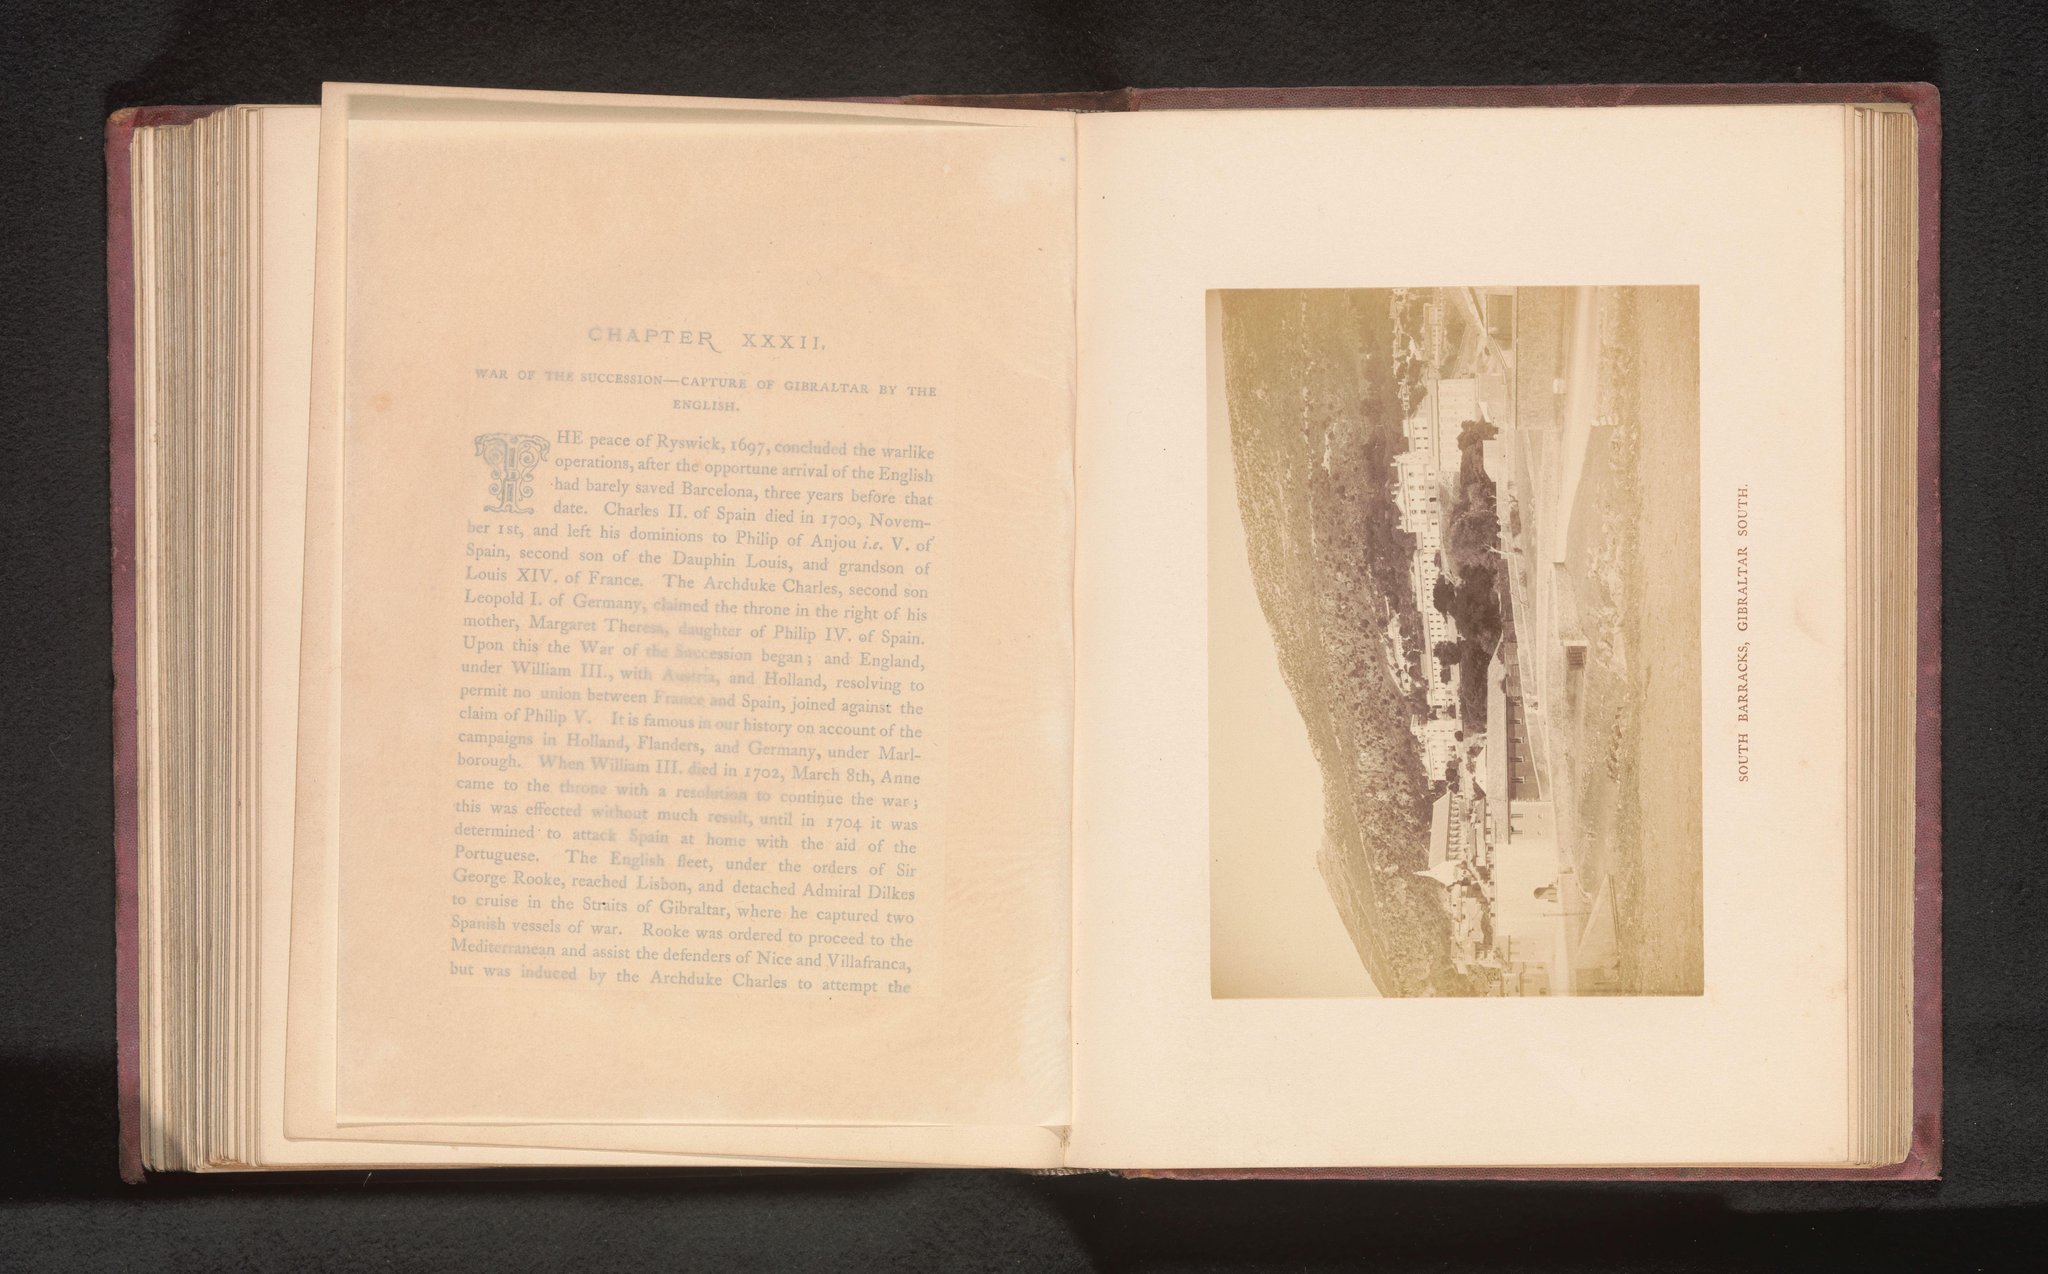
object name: page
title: South barracks, Gibraltar South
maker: j.h. mann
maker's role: fotograaf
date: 1860-1870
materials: photographic support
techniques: albumen print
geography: gibraltar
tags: façade (of house or building), barracks